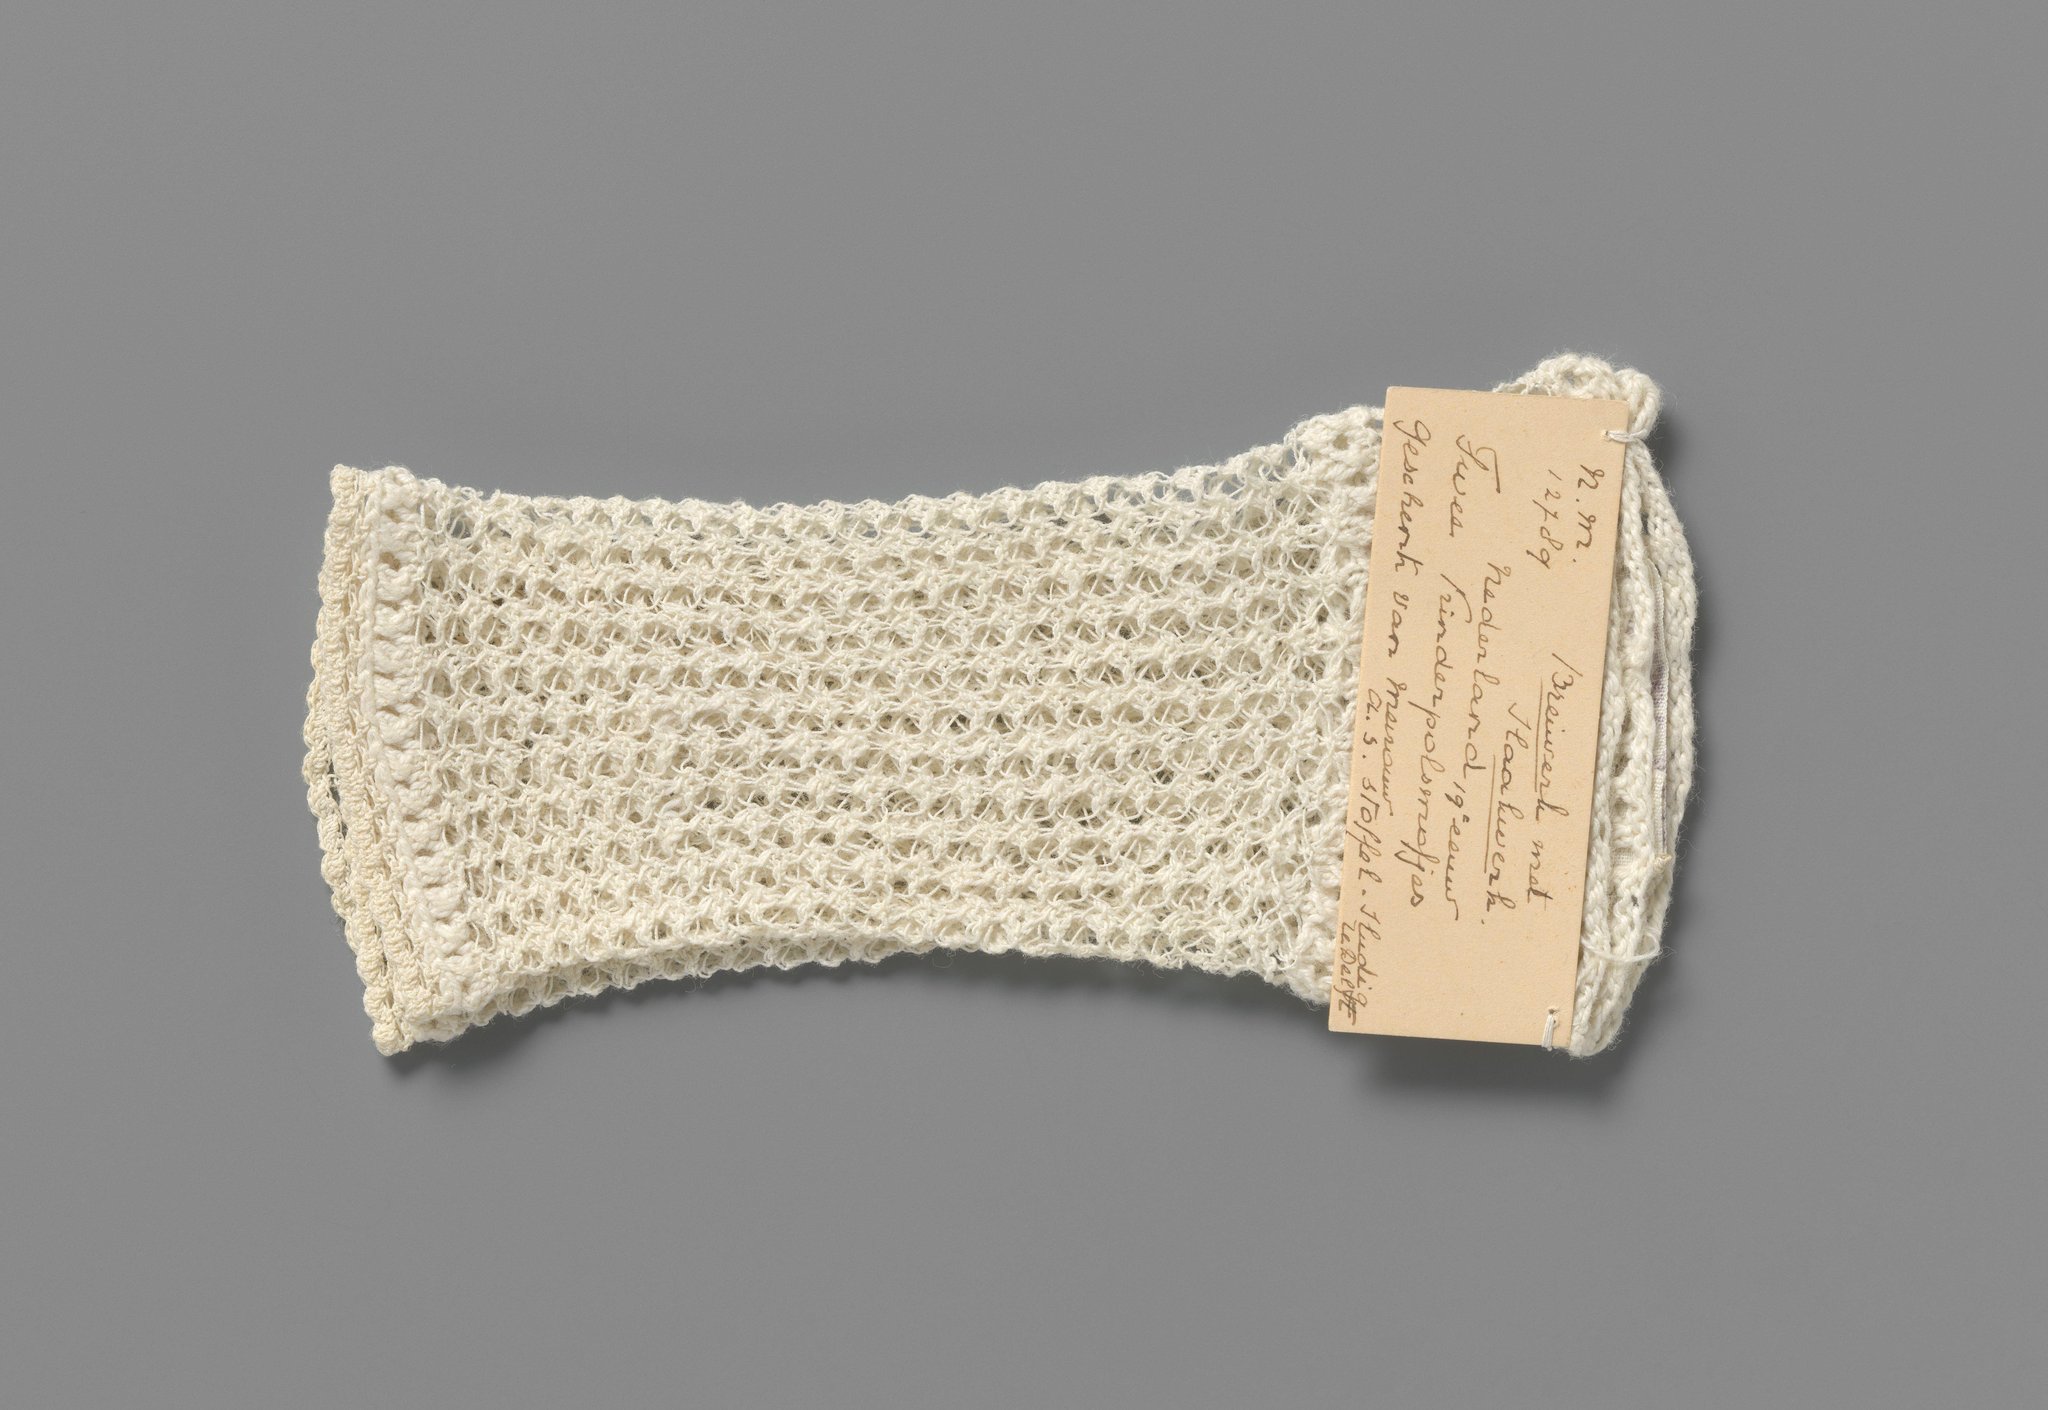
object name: mitt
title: Mitaine van witte katoen met open breiwerk en afgezet met haakwerk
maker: Anonymous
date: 1800-1900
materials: cotton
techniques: crochet, embroidery, knitting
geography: netherlands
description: Mitaine van witte katoen met open breiwerk, met haakwerk afgezet voor een baby of kind.